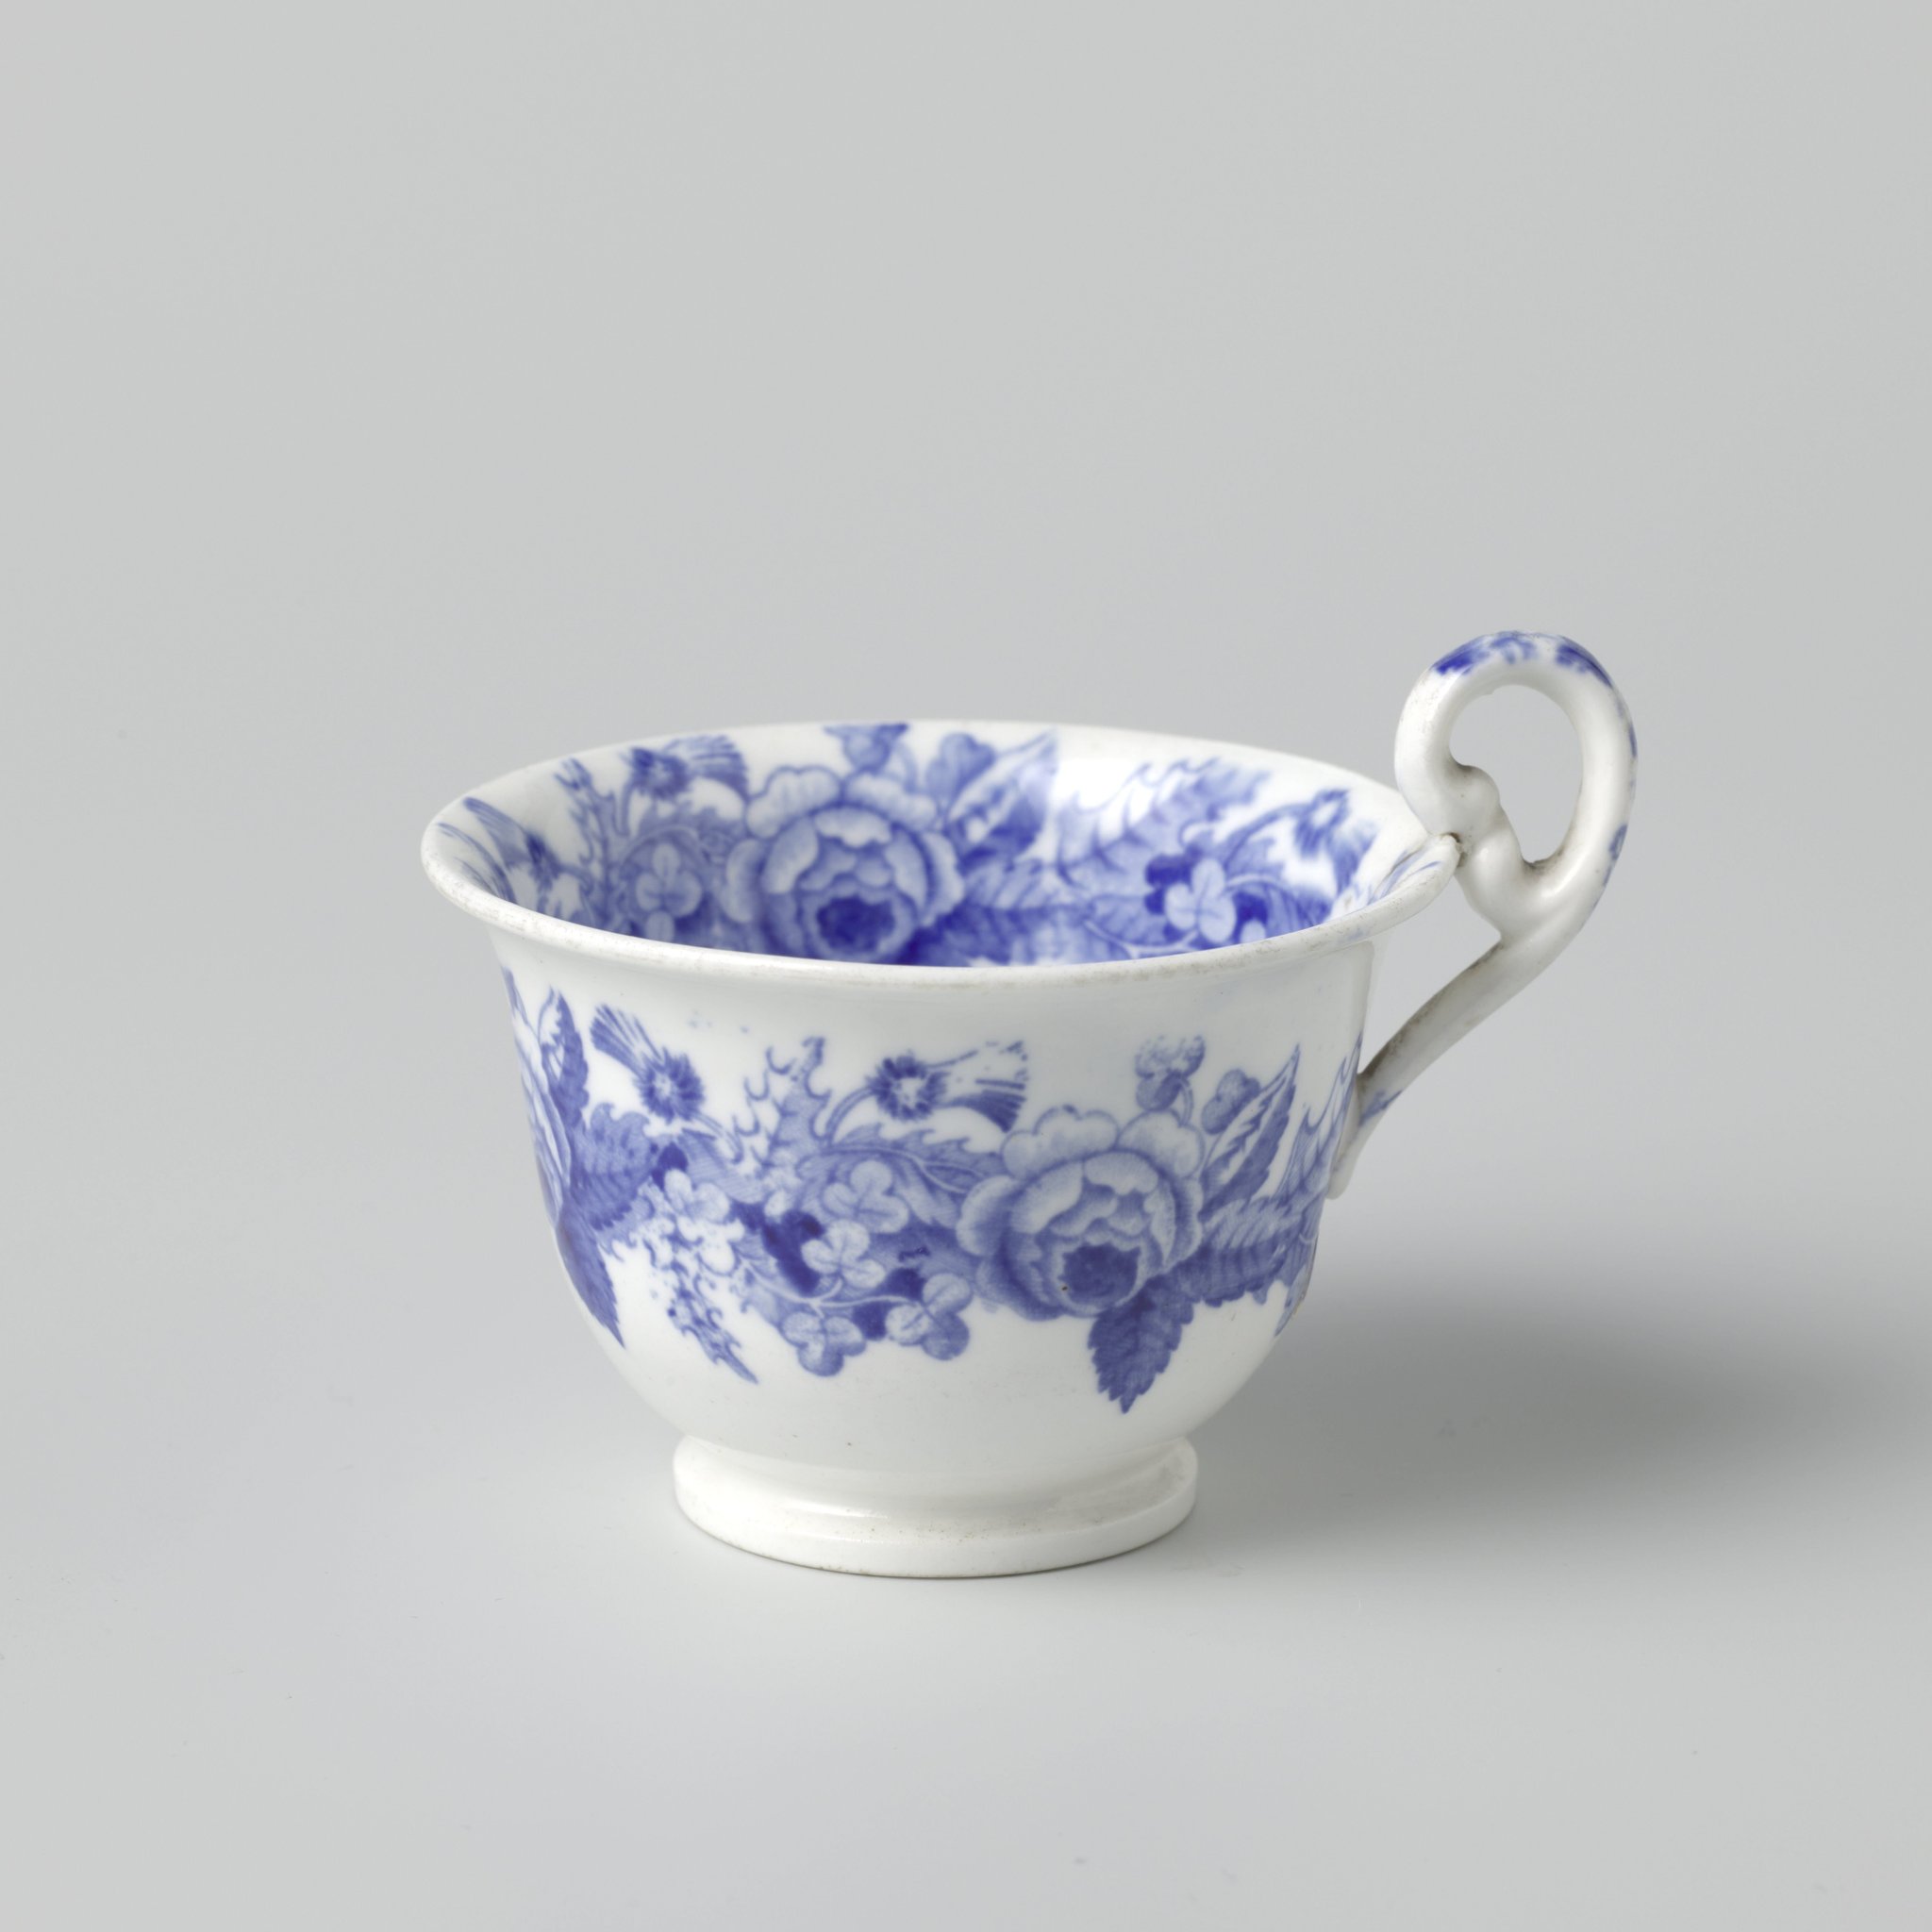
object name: cup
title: Kop van porselein, pate tendre, versierd in blauw en wit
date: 1775-1824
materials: porcelain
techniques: painted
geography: stoke-on-trent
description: Kop van porselein, pate tendre, versierd in blauw en wit met een krans van bloemen en bladeren. Bijbehorende schotel (b).